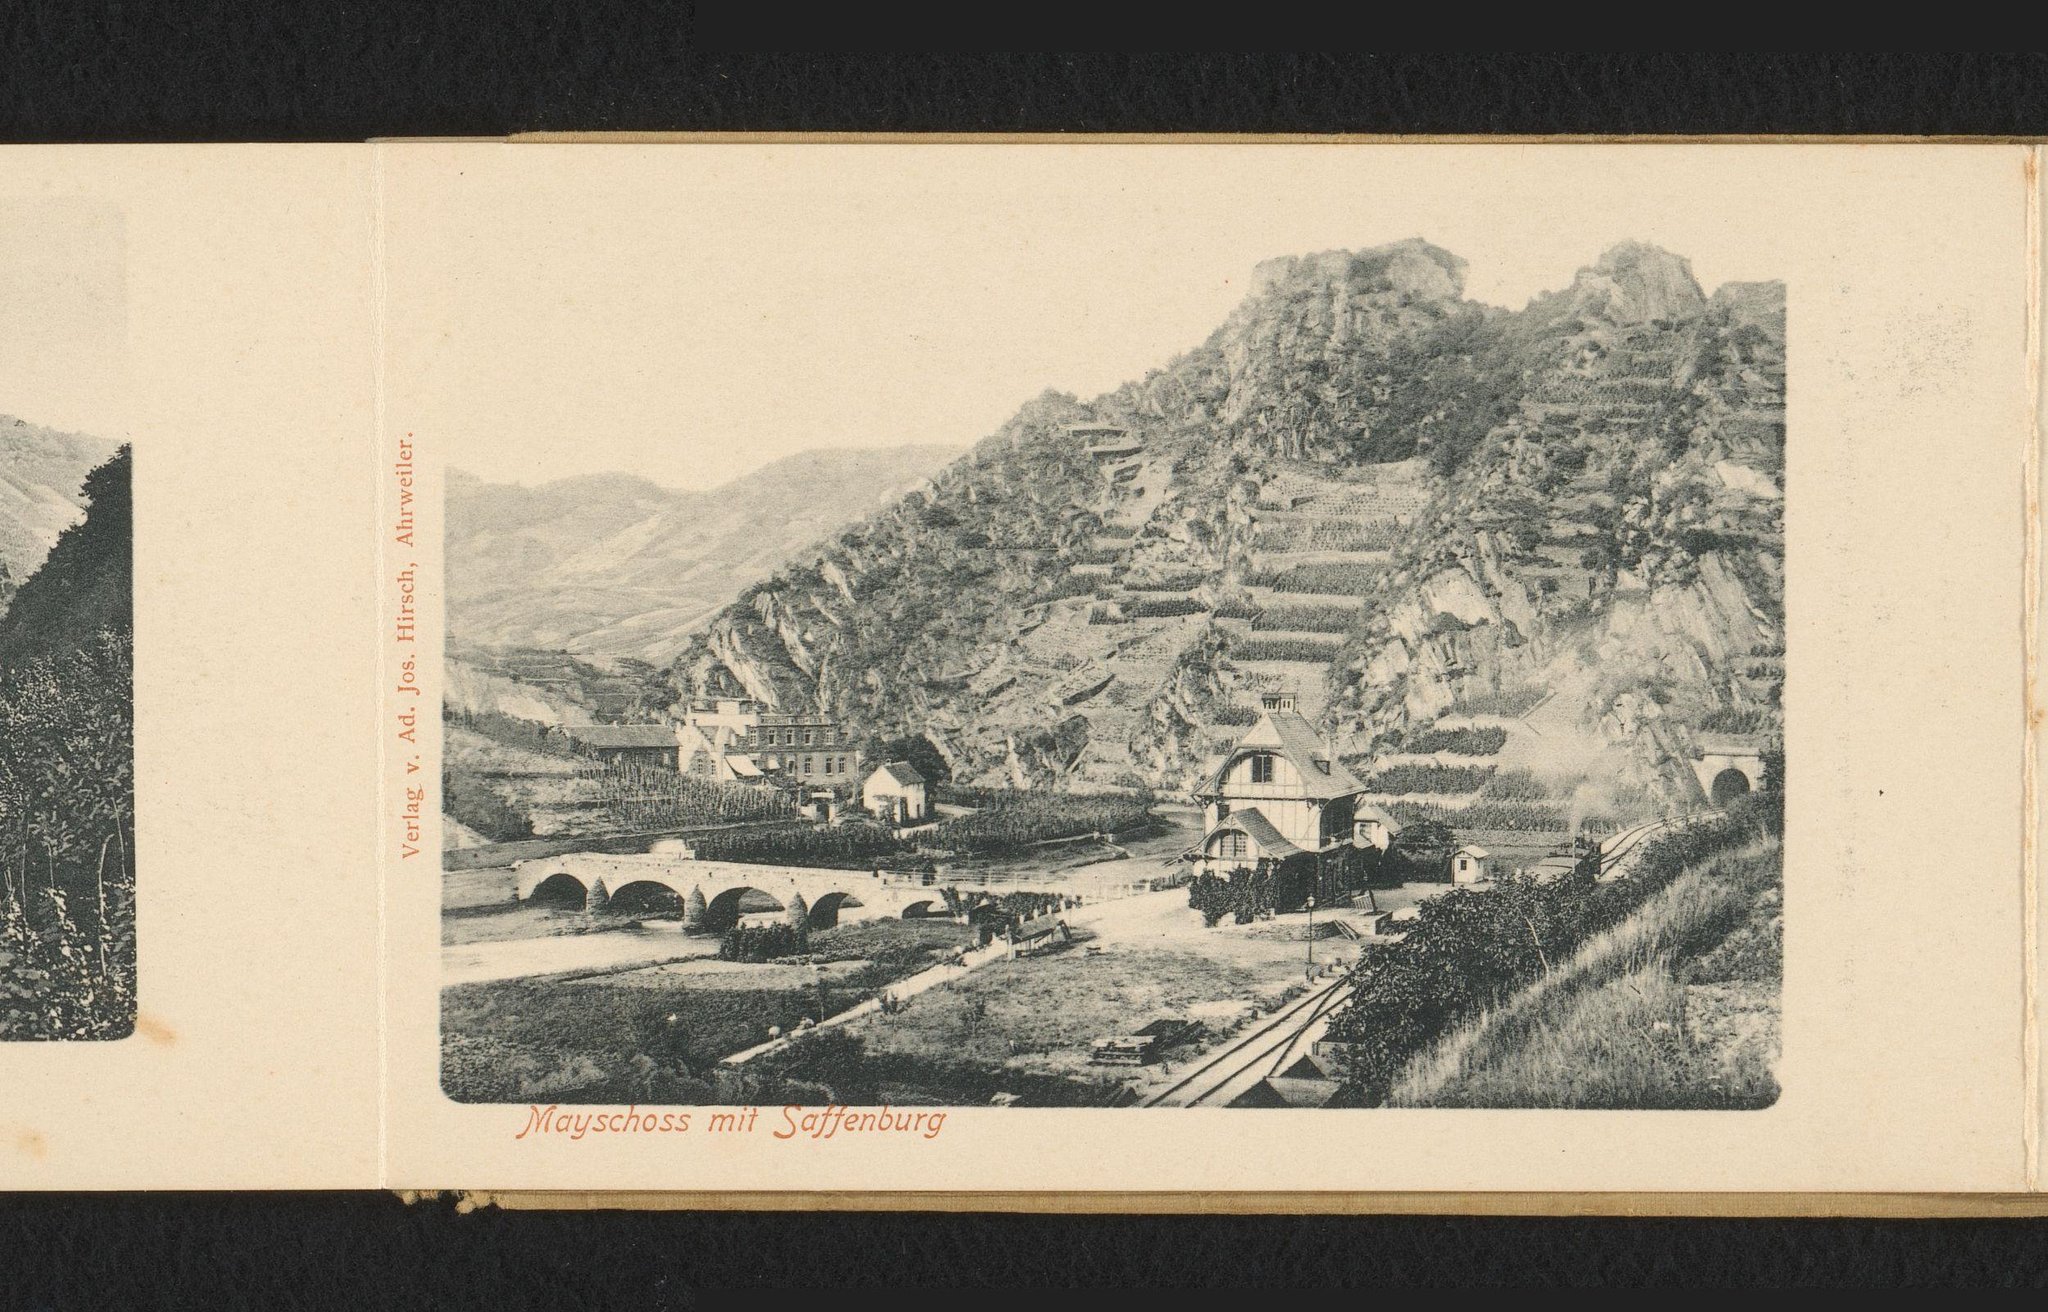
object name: photomechanical print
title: Mayschoss mit Saffenburg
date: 1885-1903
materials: cardboard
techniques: photograph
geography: ahrweiler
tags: city-view, and landscape with man-made constructions, ruin of a dwelling, house, castle, etc., mountains